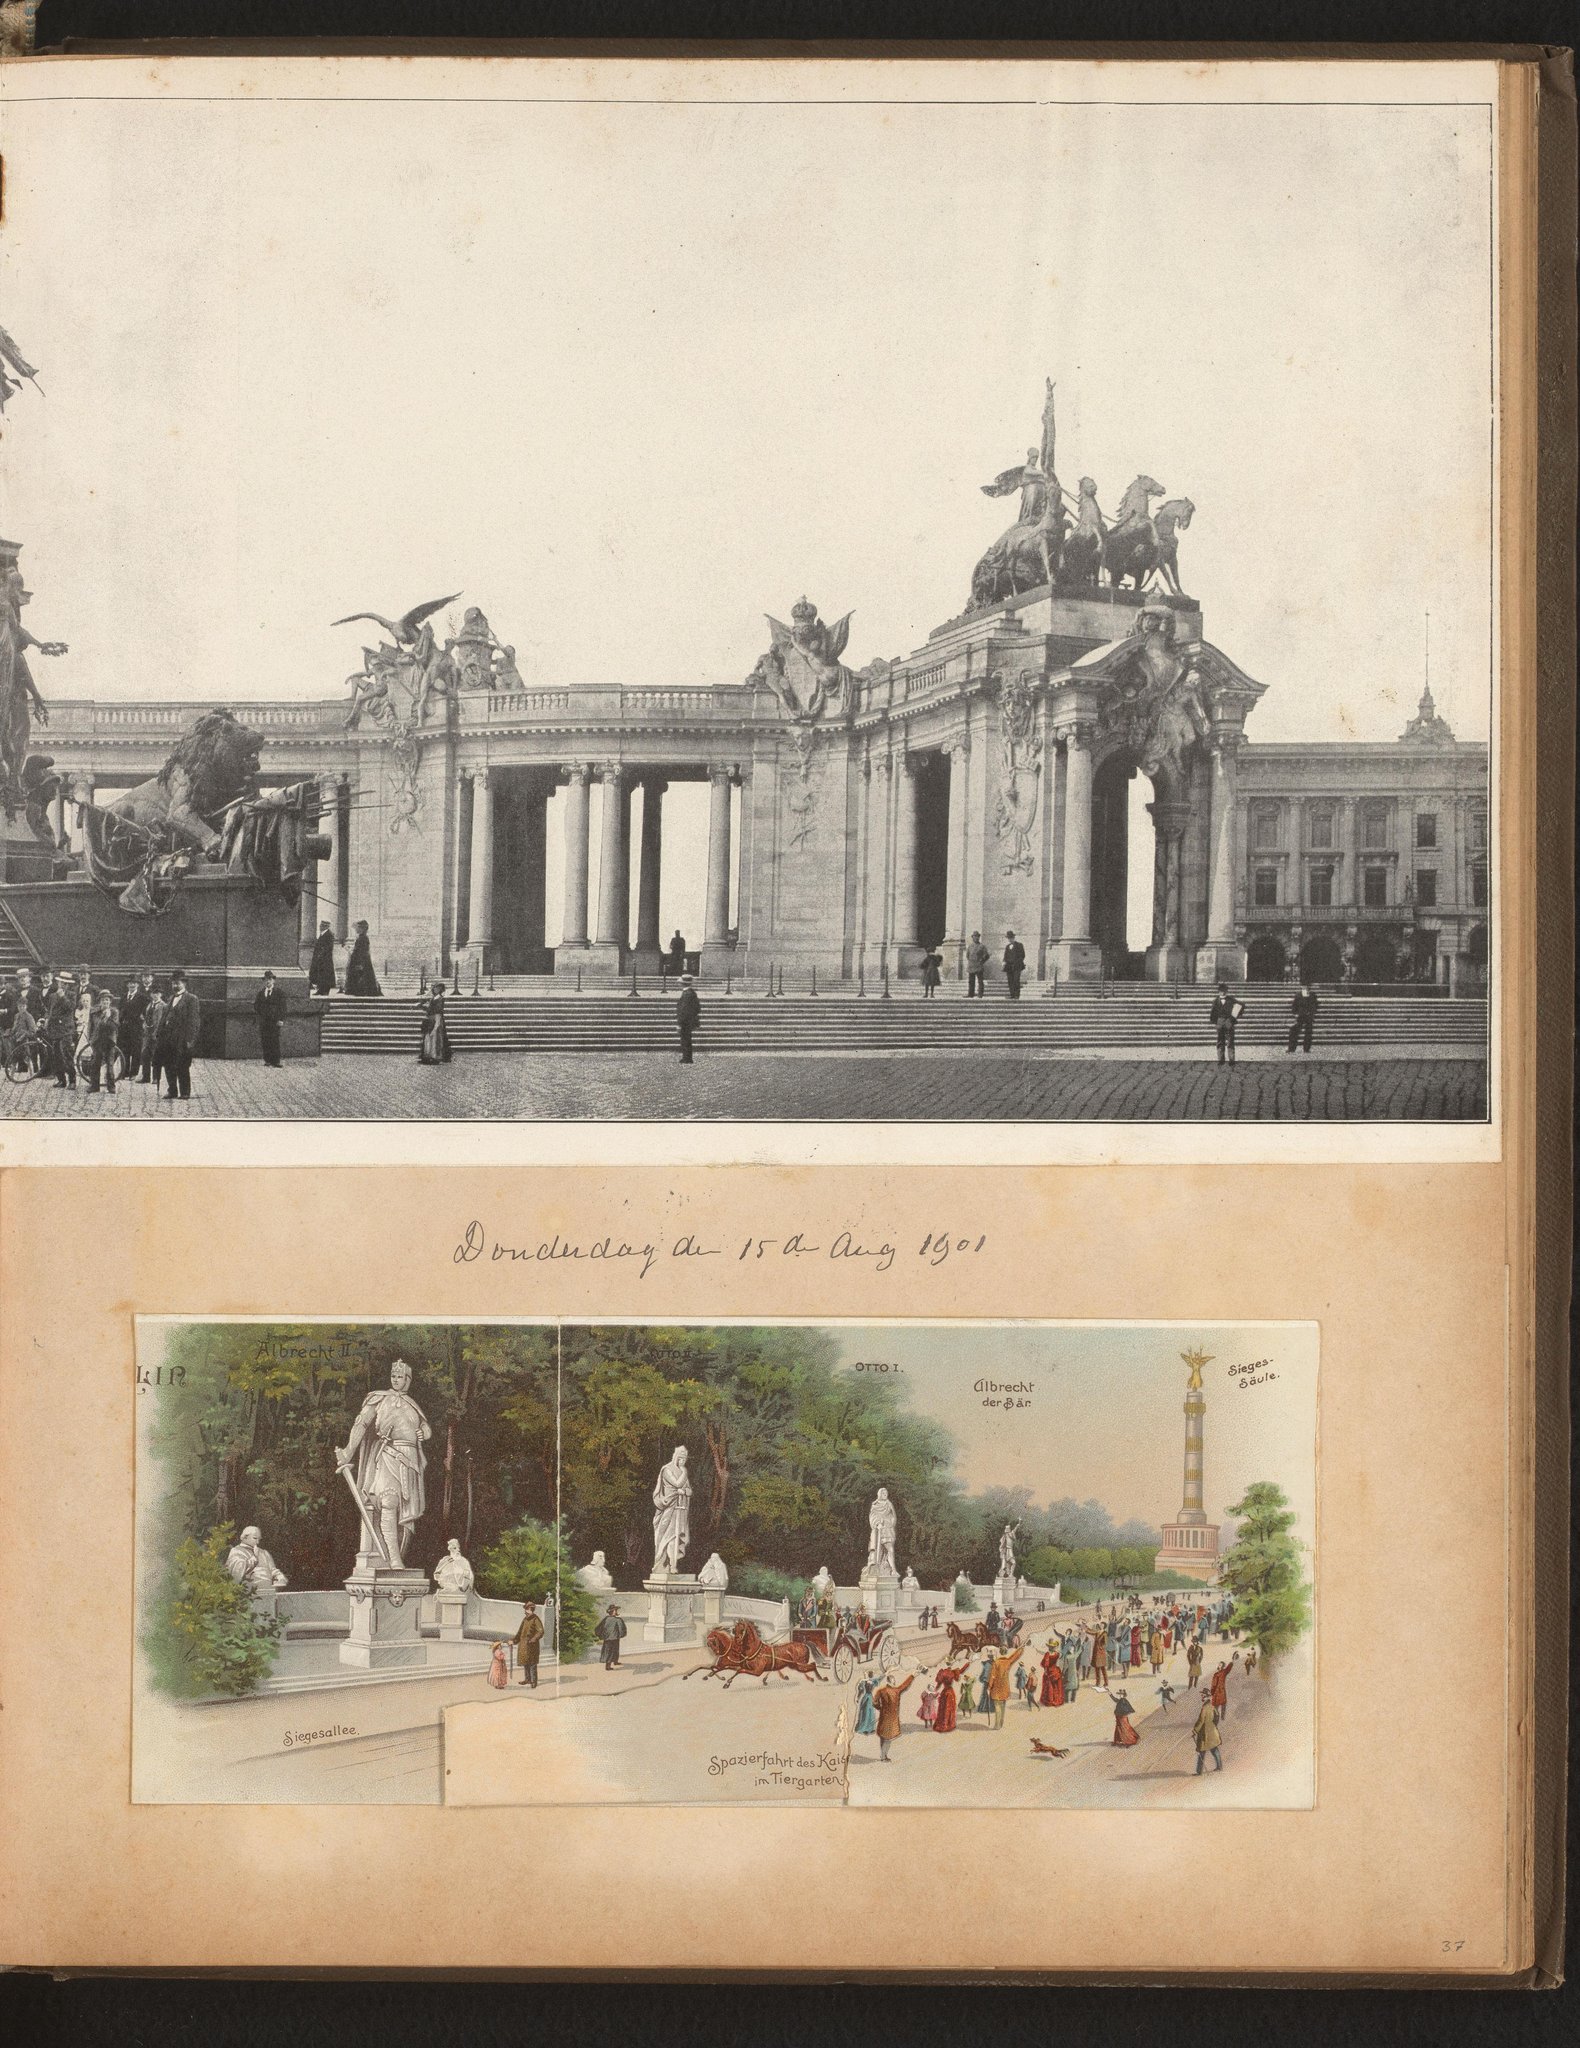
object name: photomechanical print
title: Gezicht op het Kaiser-Wilhelm-Nationaldenkmal en een prentbriefkaart van de Siegesallee, Berlijn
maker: Anonymous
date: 1897-1901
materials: cardboard, paper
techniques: lithograph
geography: berlin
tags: piece of sculpture, reproduction of a piece of sculpture, monument, statue, four-wheeled vehicle drawn by two animals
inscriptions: inscription: ‘Donderdag den 15de Aug 1901’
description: De bovenste prent op deze pagina loopt door op de vorige pagina; zie RP-F-2003-40-36.